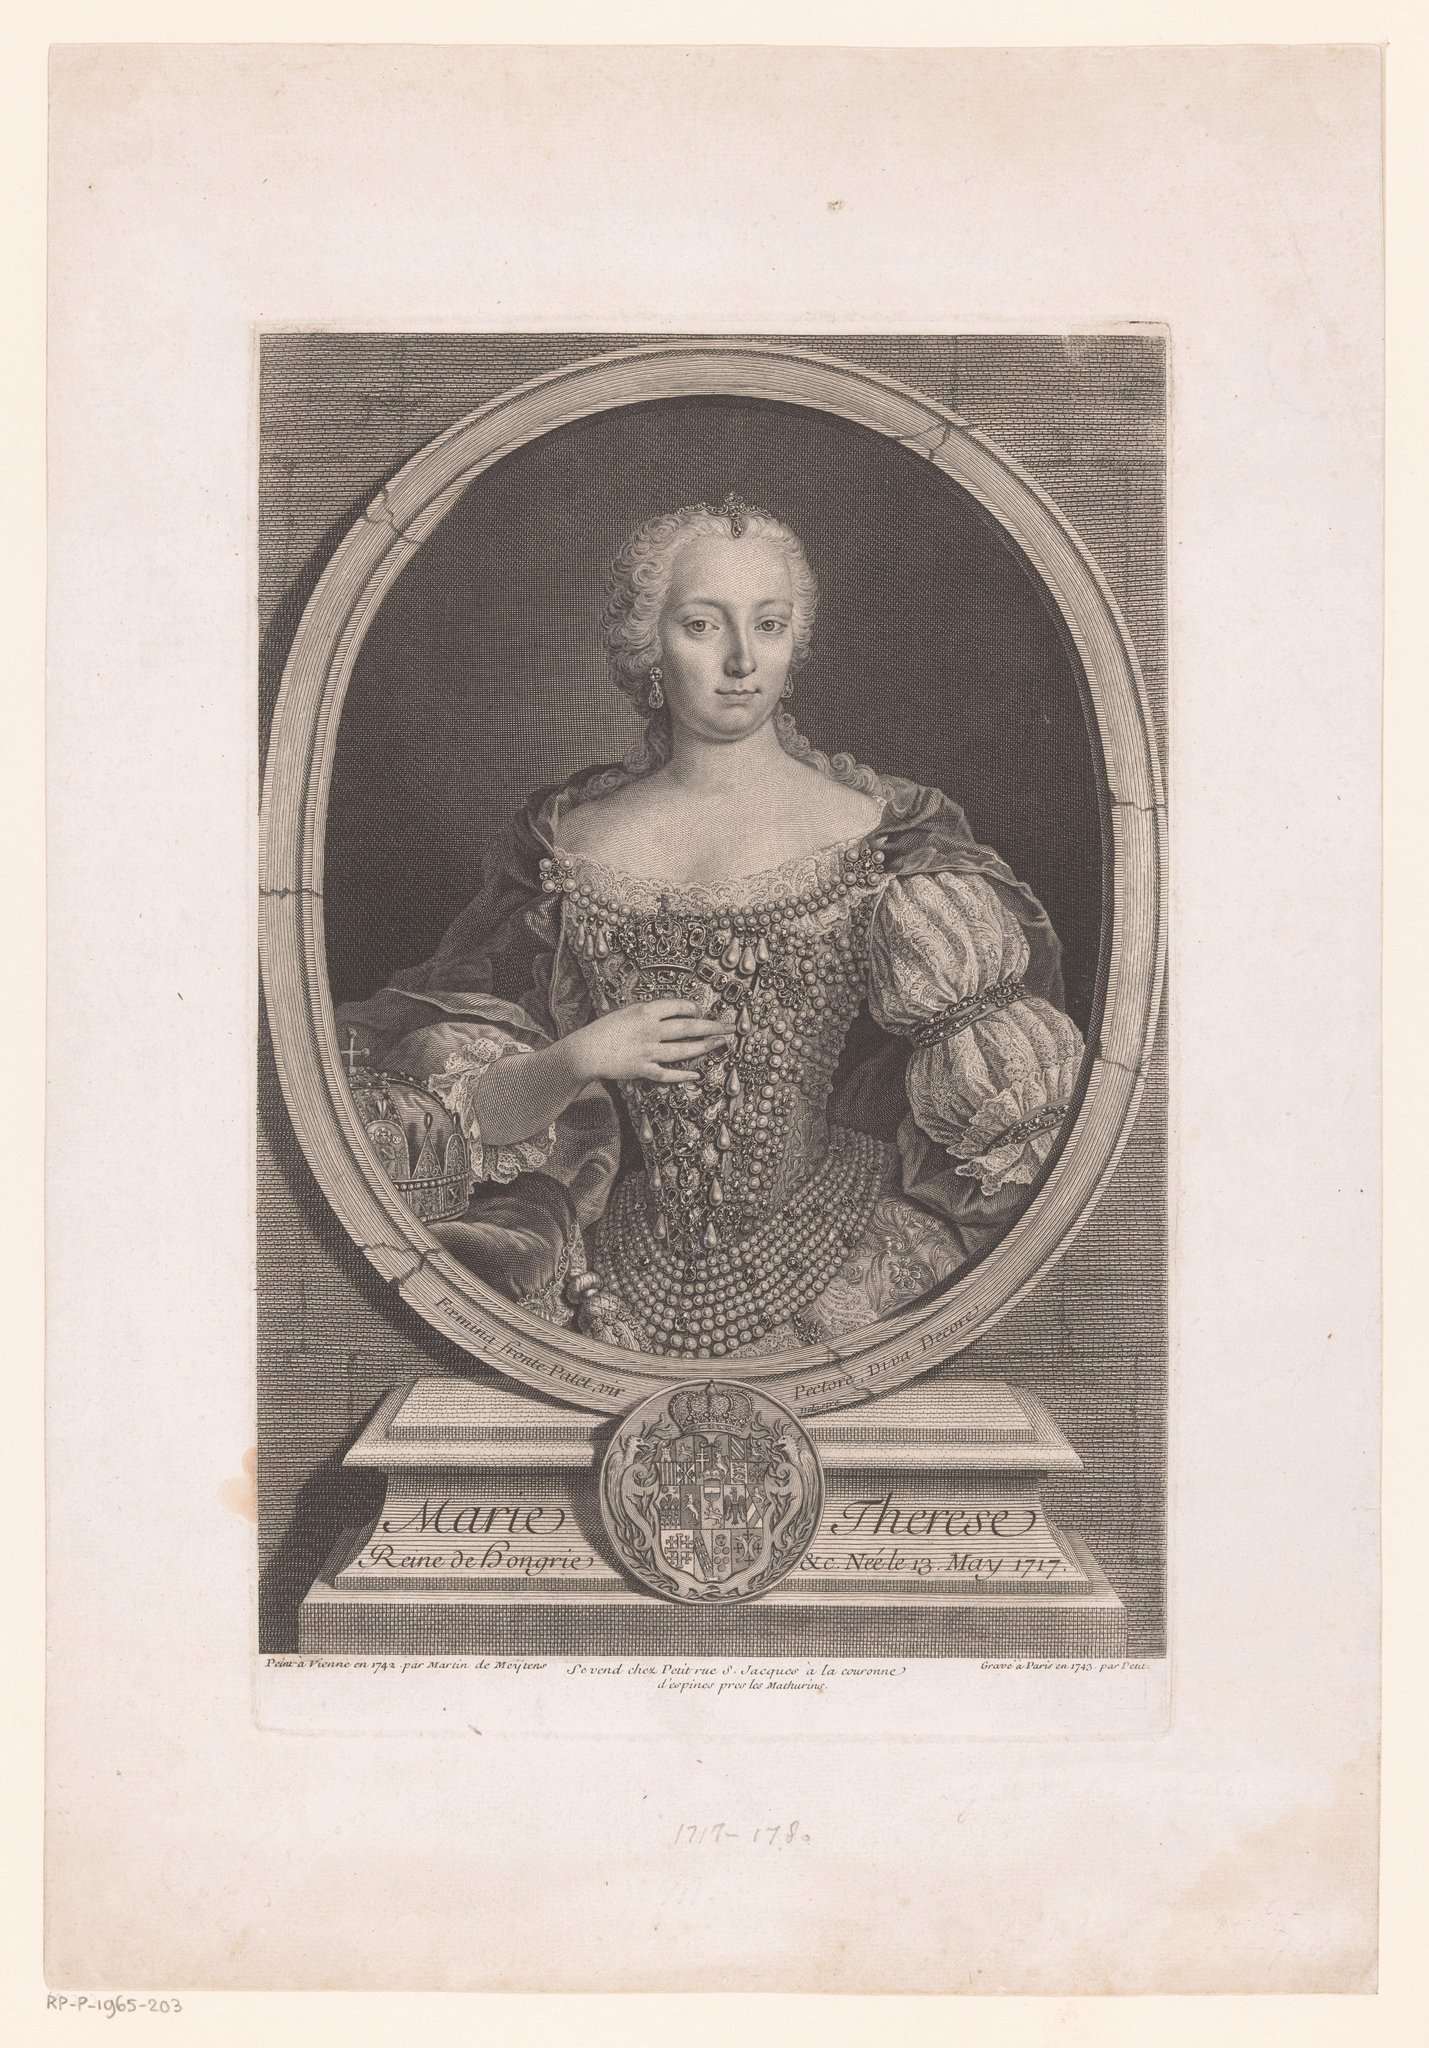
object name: print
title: Marie Therese Reine de Hongrie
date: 1743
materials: paper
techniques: engraving, etching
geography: vienna state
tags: vienna, maria theresia (rooms-duits keizerin), historical persons - bb - woman, emperor - bb - female ruler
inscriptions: collector's mark: Lugt 2760, collector's mark: Lugt 2228